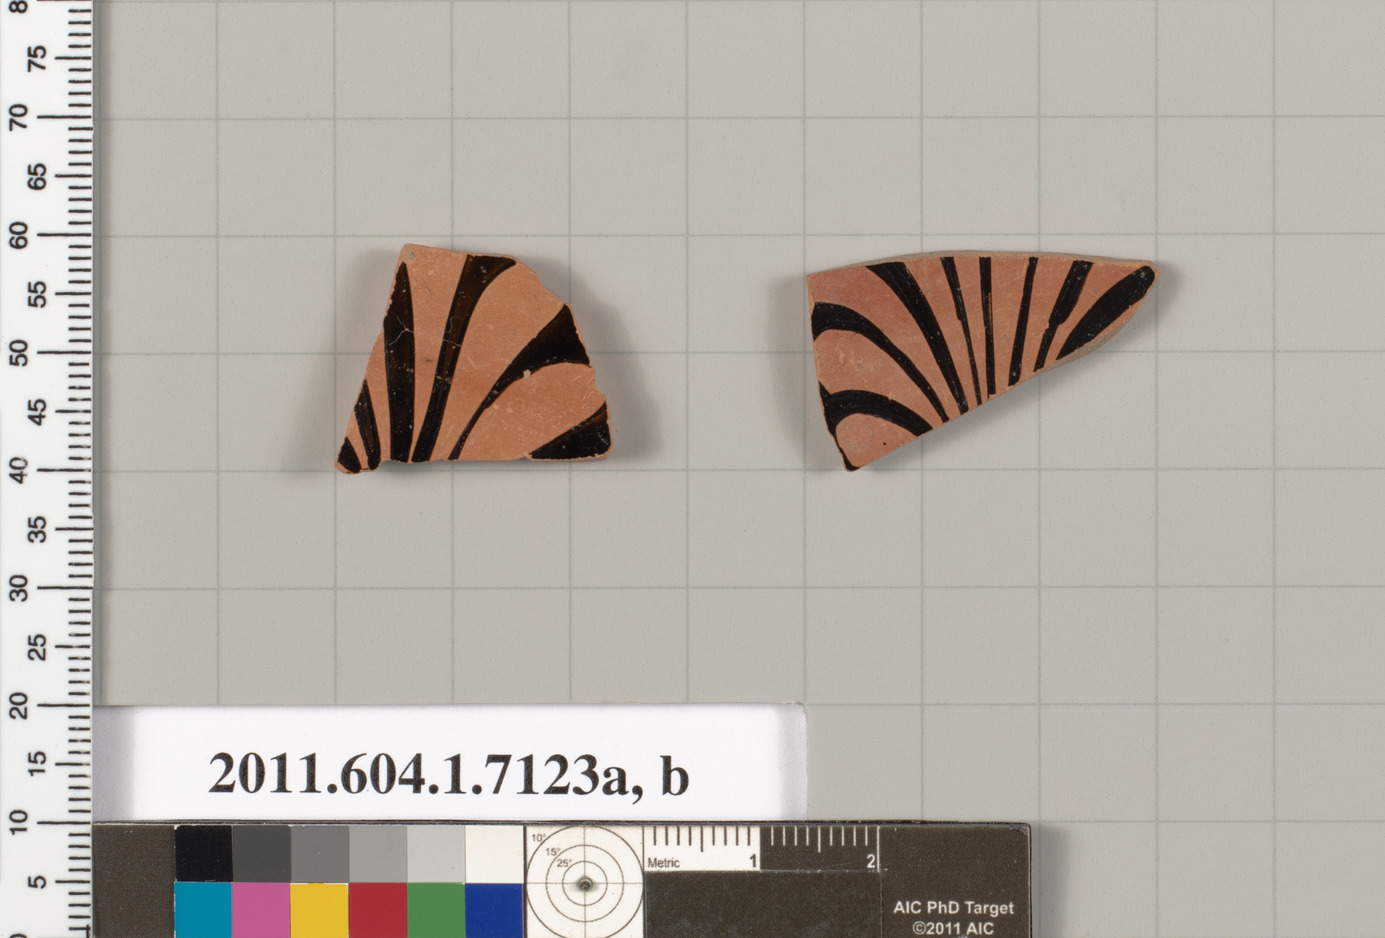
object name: kylix fragment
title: Terracotta fragments of kylikes (drinking cups)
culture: greek, attic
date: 500-480 BCE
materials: terracotta